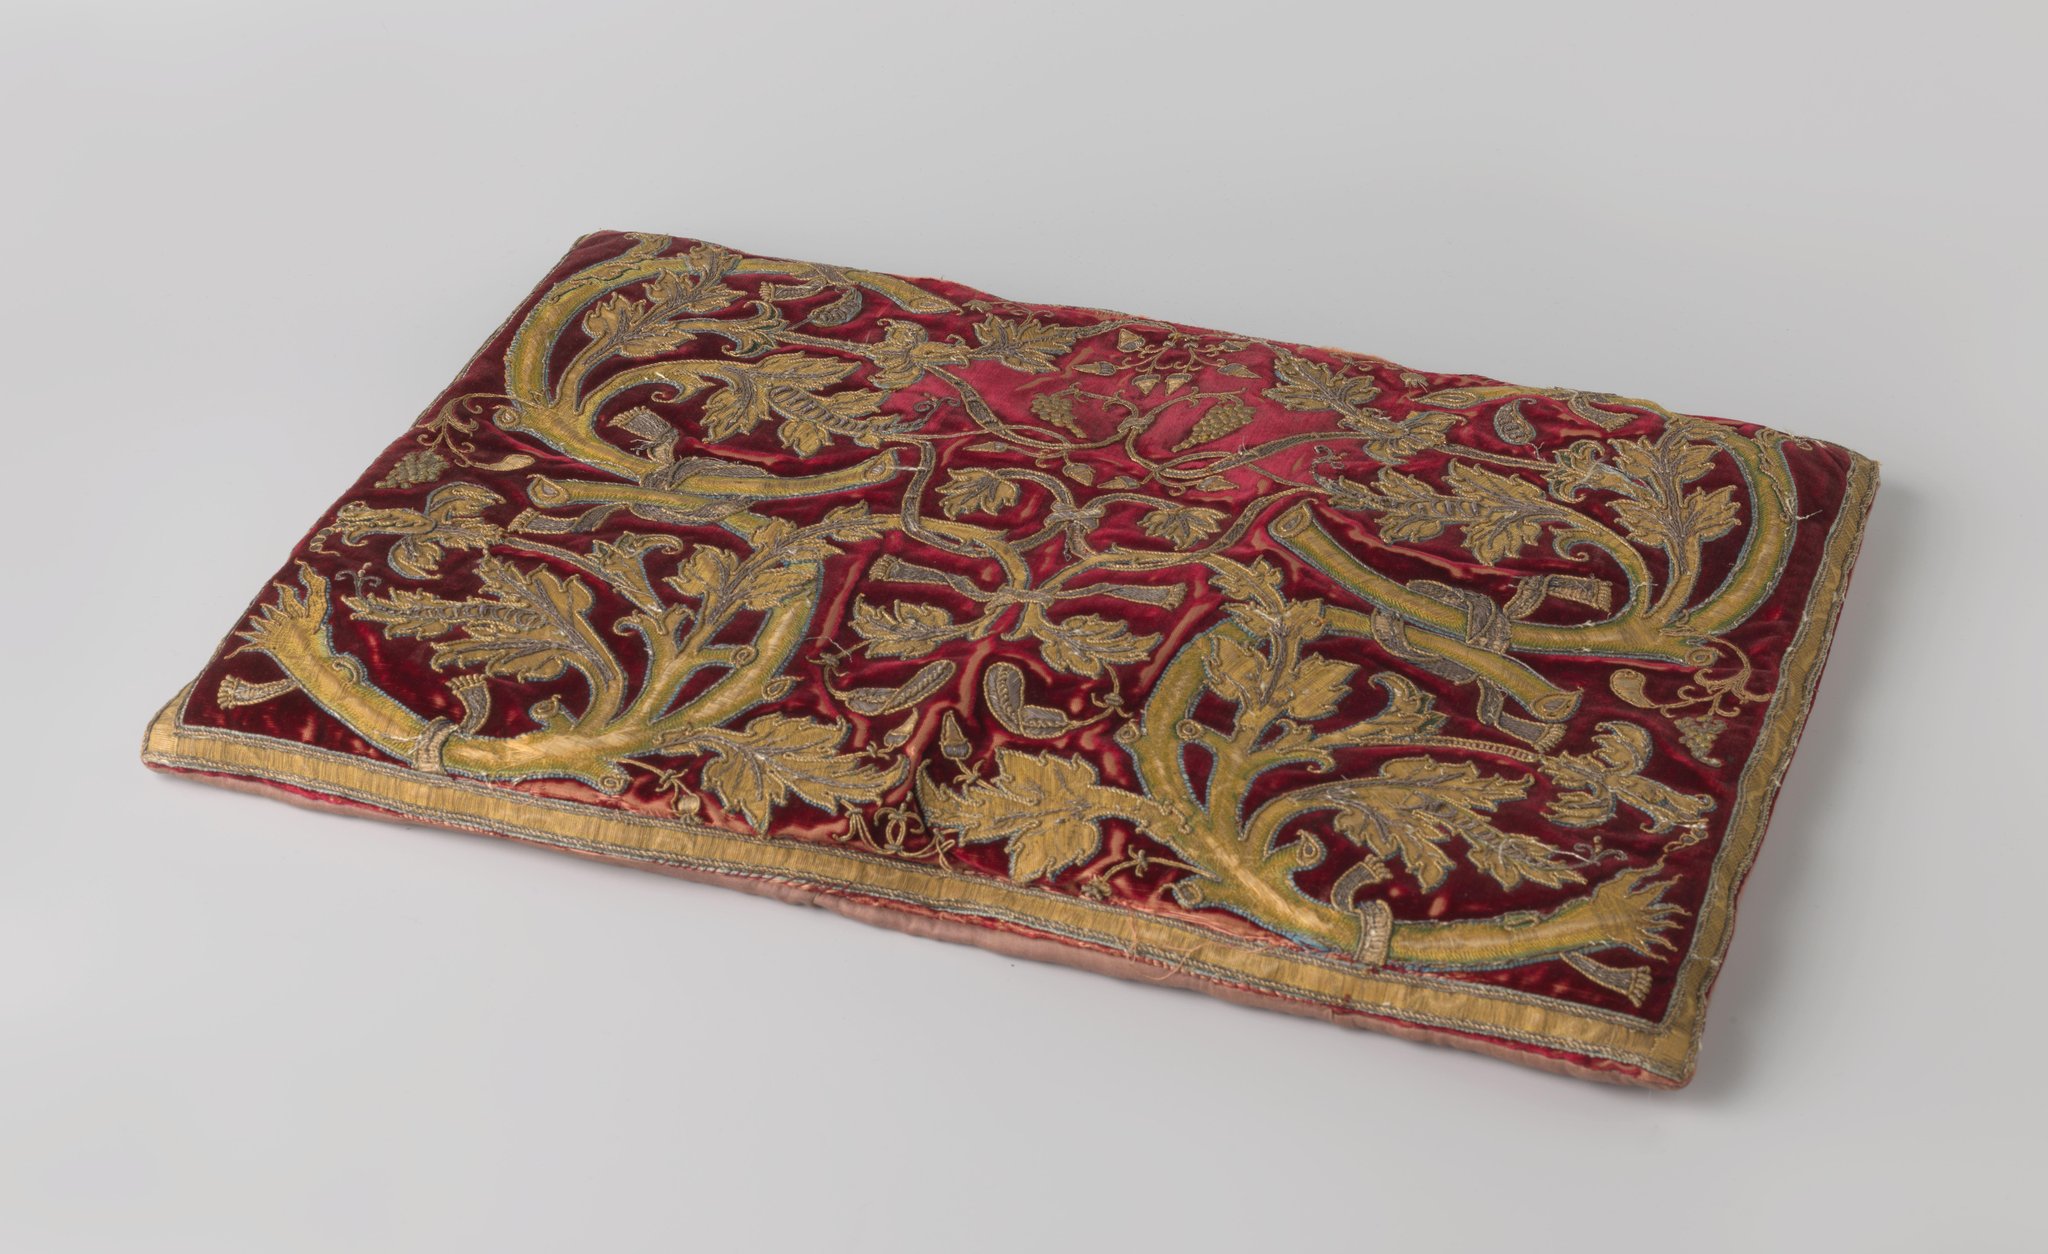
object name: top cover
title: Stoelrug van wijnrood fluweel met applicatie-borduurwerk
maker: Anonymous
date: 1500-1599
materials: thread, velvet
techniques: brocade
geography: italy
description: Stoelrug van wijnrood fluweel met applicatie-borduurwerk. Aan de korte zijden staan afgeknotte takken omwonden door een lint. Zijtakken met acanthusblad en eindigend in lelie, eikels, korenaar en druiventrossen. Applicatie van goudbrokaat geborduurd met groene en gele zijde. Langs de contouren gelegd goud en blauw koord. Bladnerven van zilverdraad.